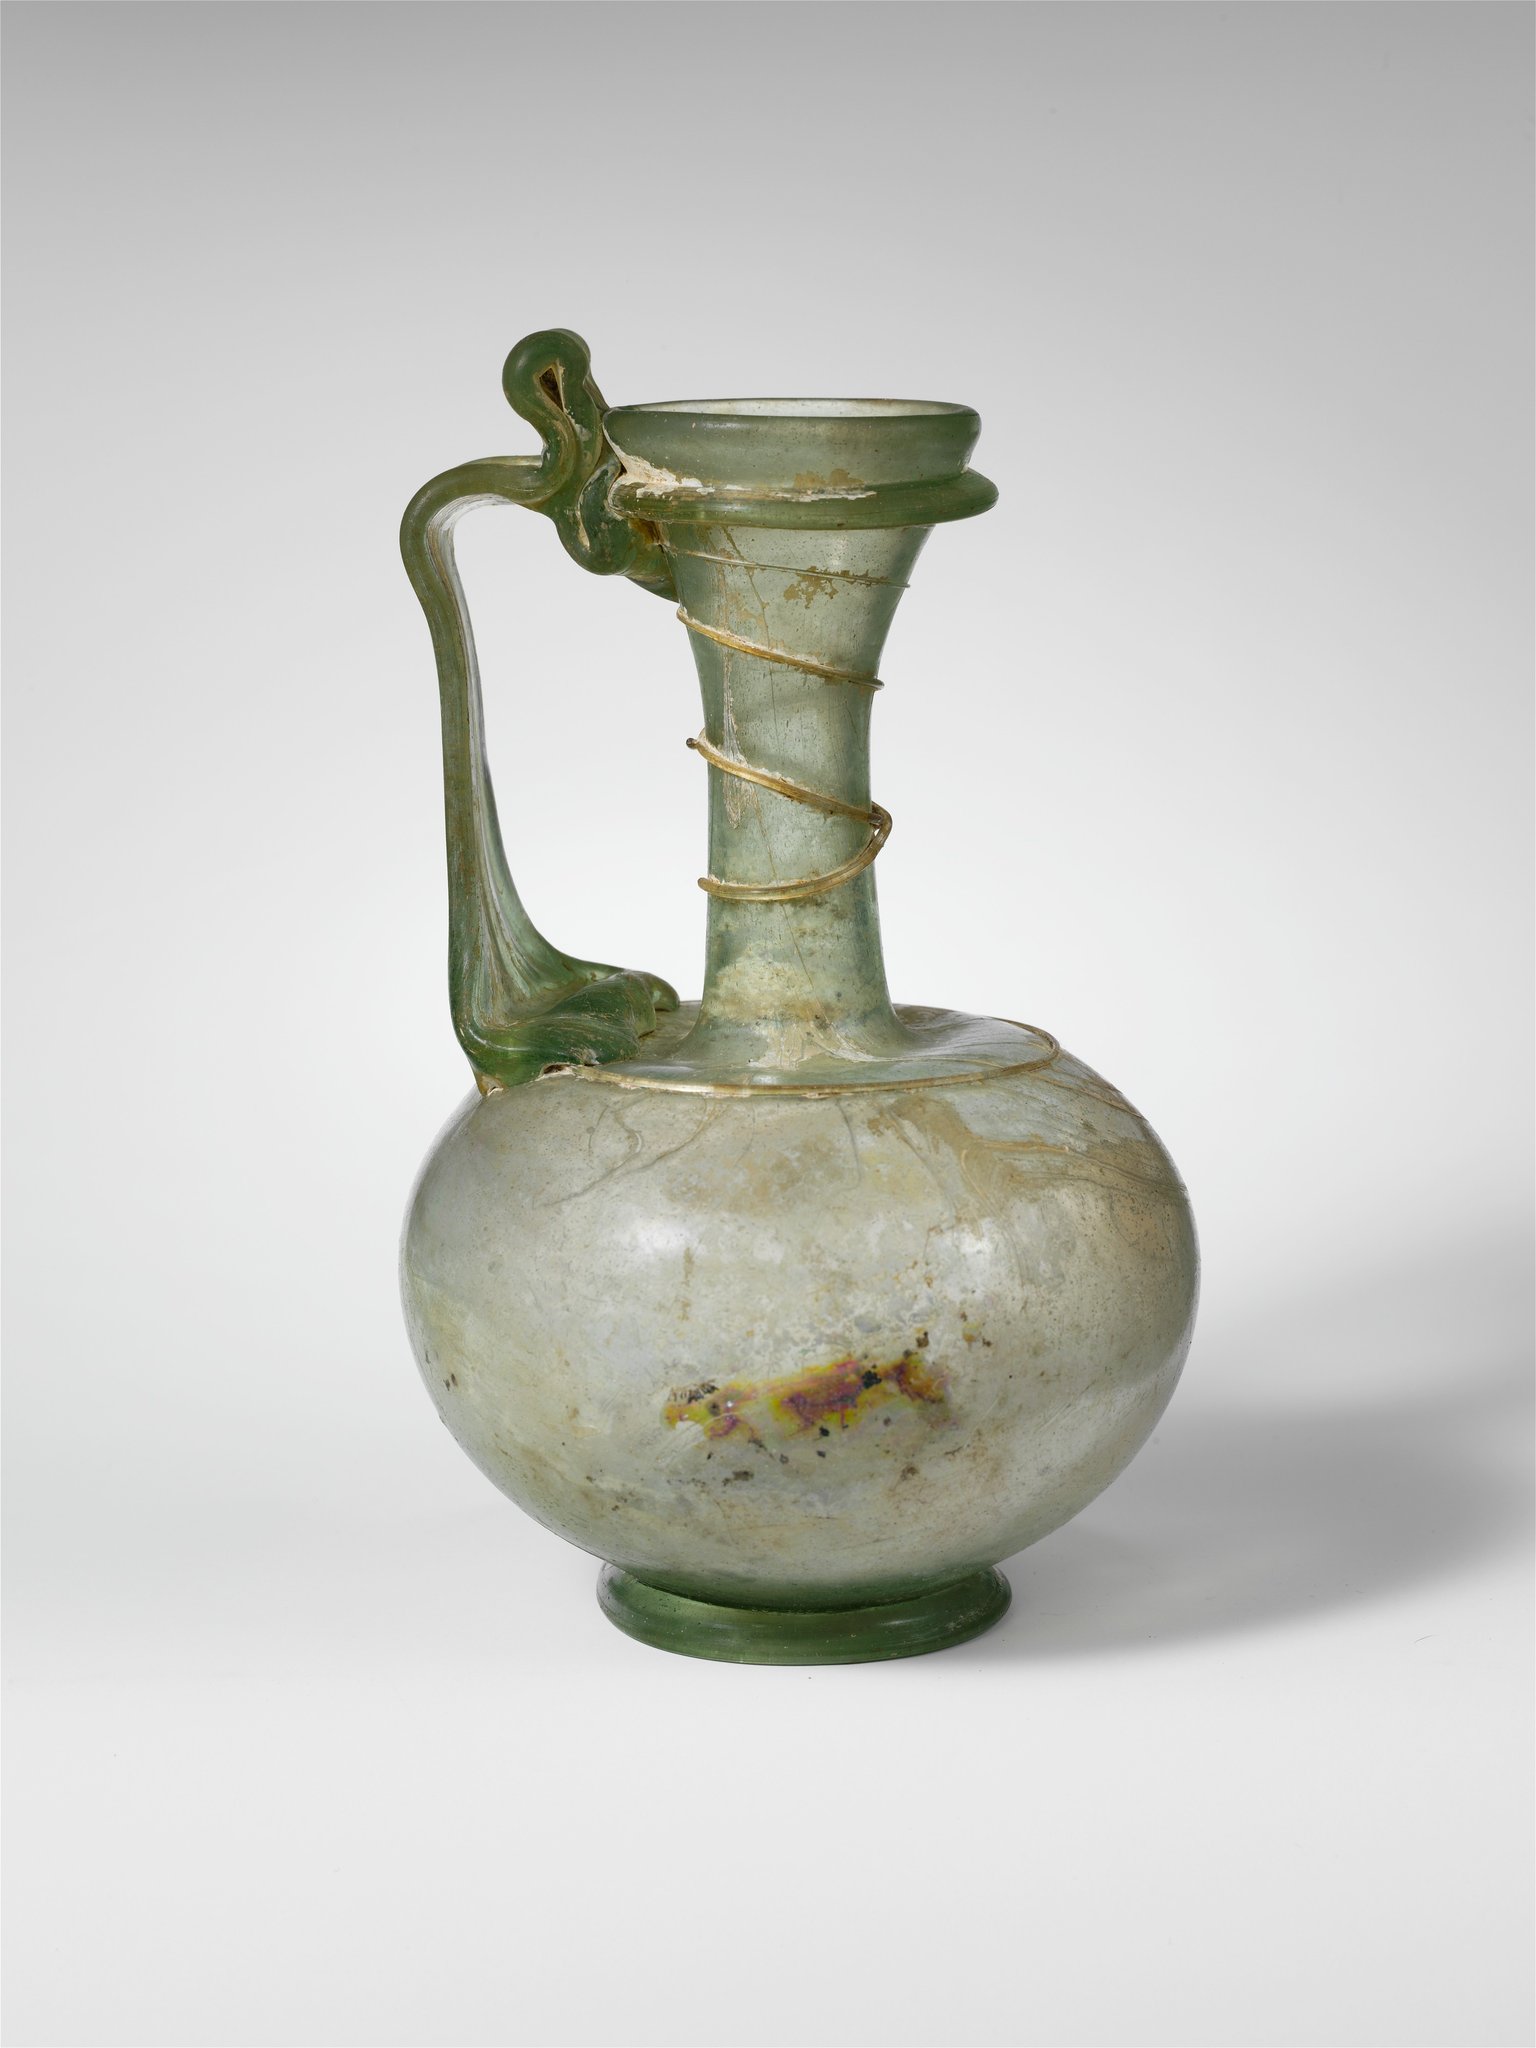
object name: jug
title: Glass jug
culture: roman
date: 301-400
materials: glass